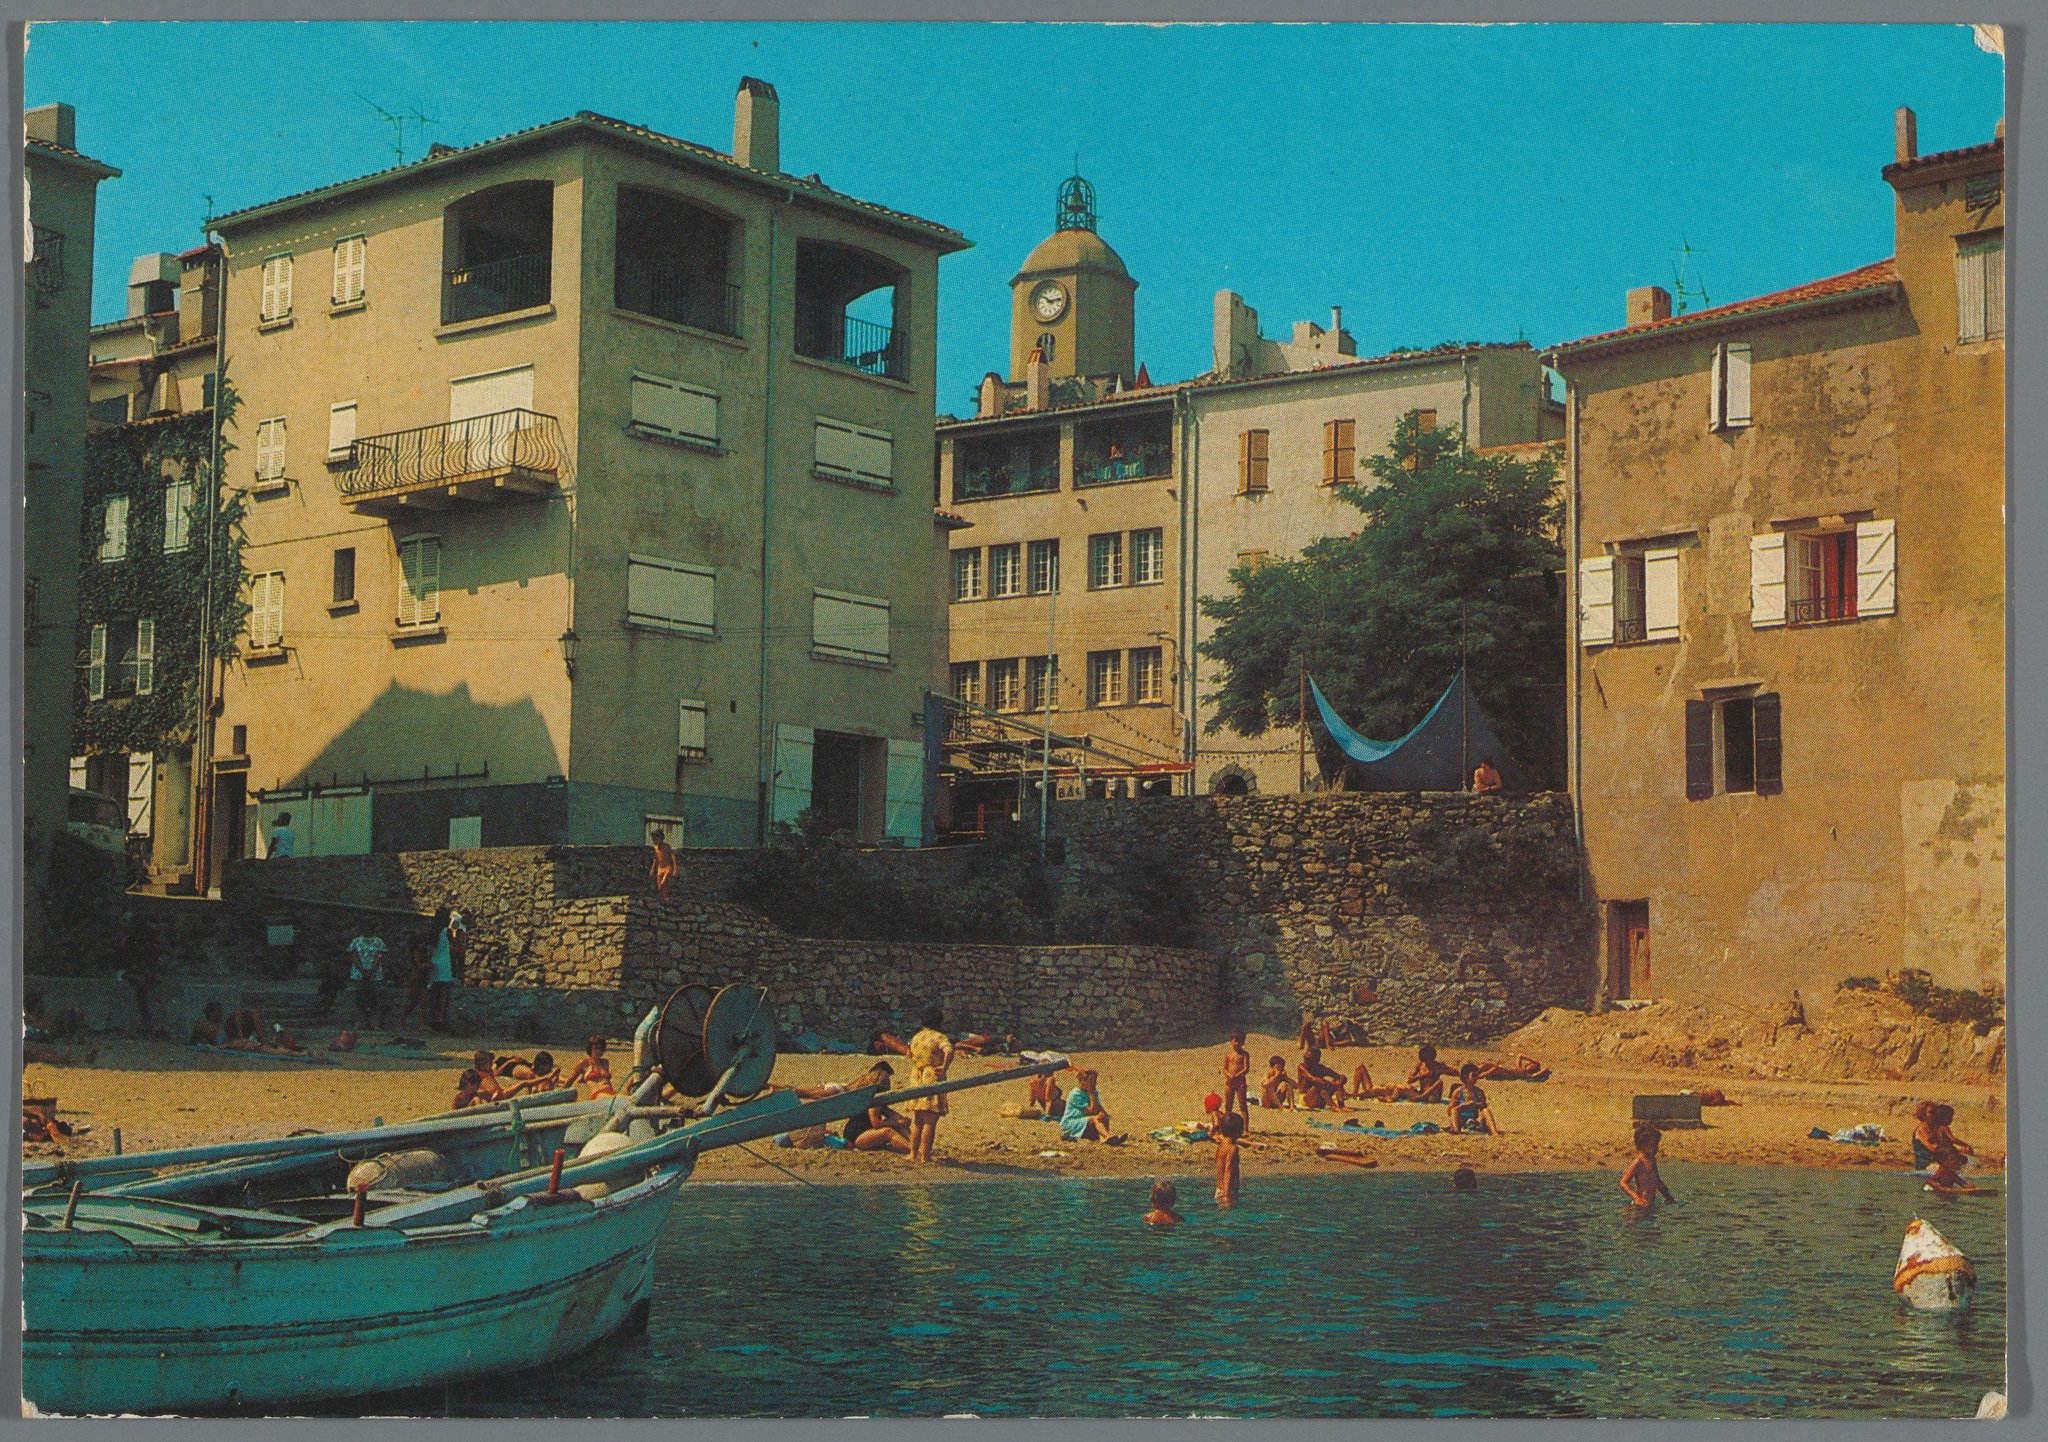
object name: postcard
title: La cote d'azur. Saint-Tropez. La Ponche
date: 1900-1925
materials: photographic support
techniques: offset printed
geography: france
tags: saint-tropez